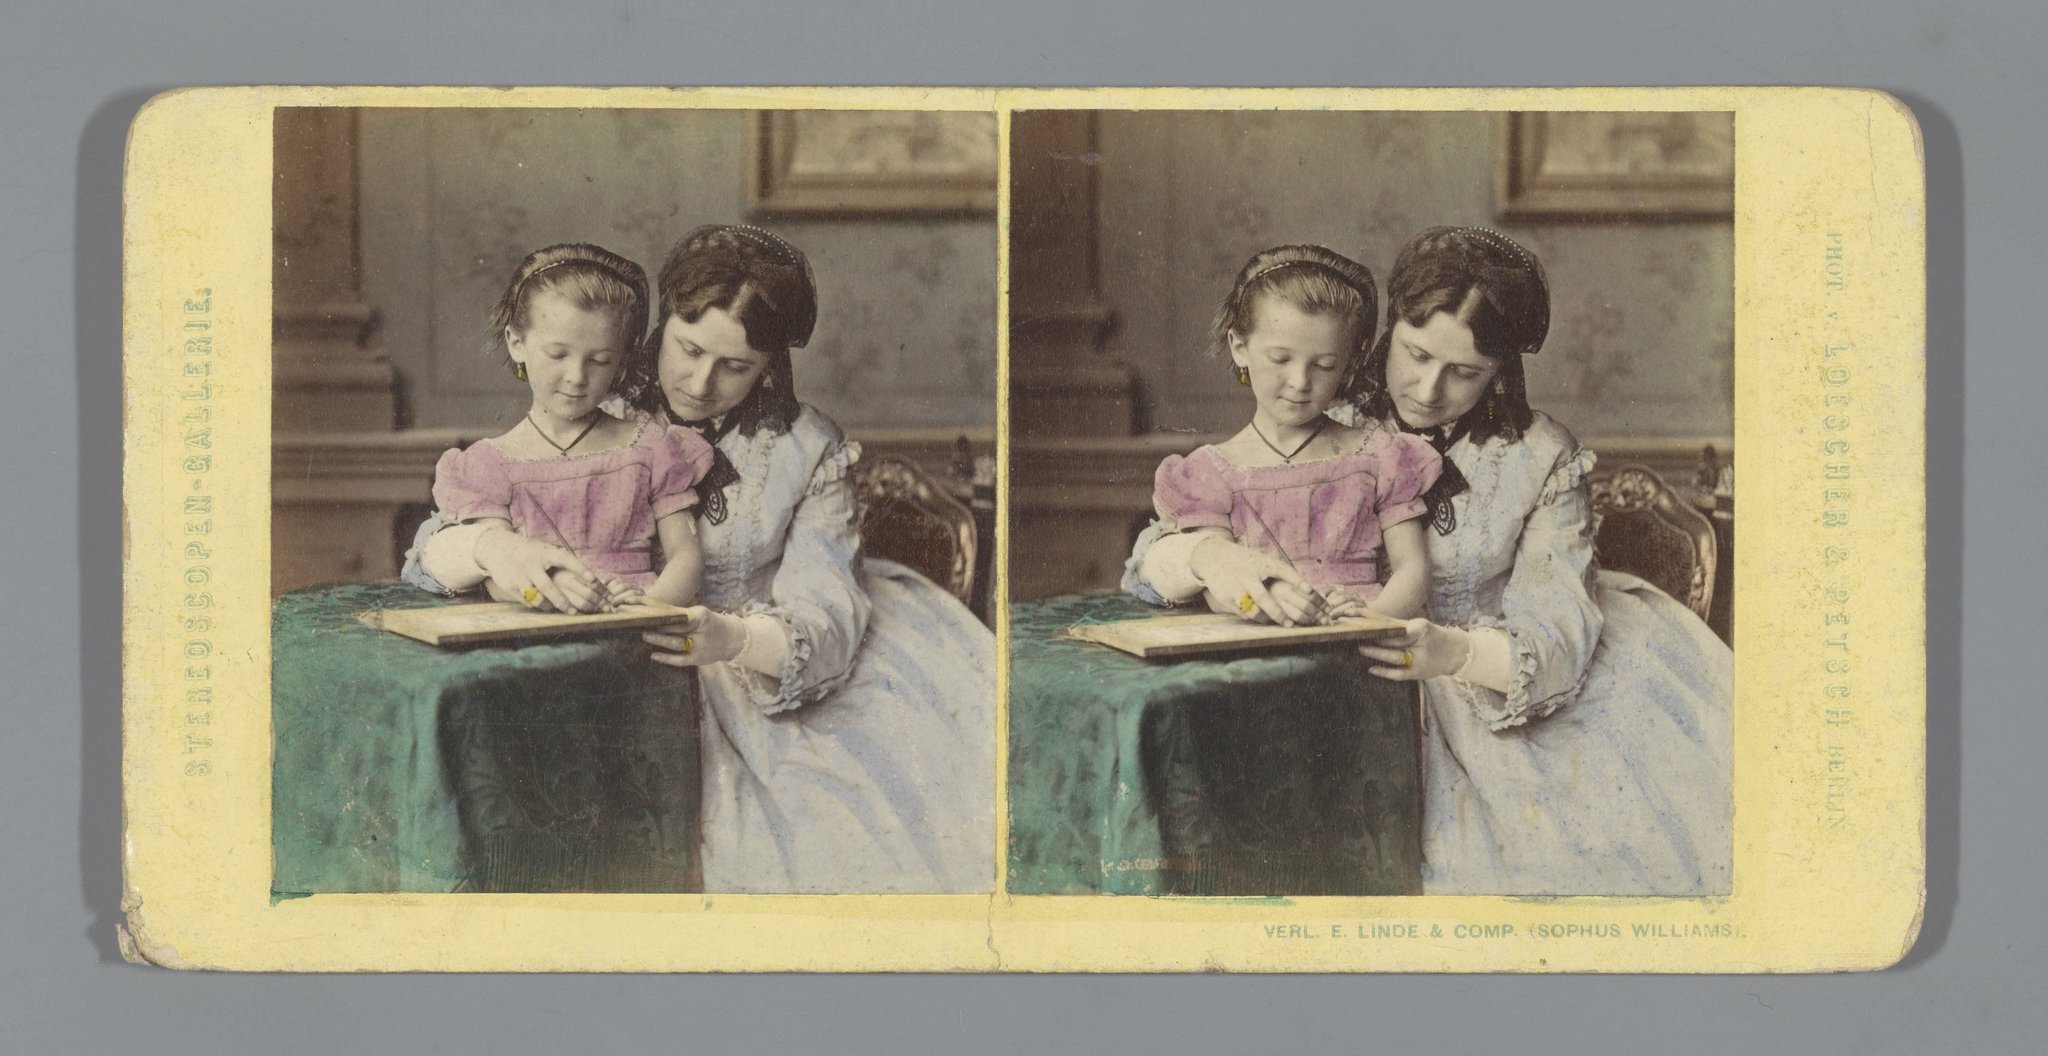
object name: stereograph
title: Stereoscopen-Gallerie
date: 1868-1900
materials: cardboard, paper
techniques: albumen print, hand coloring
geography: berlin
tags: adult woman, child